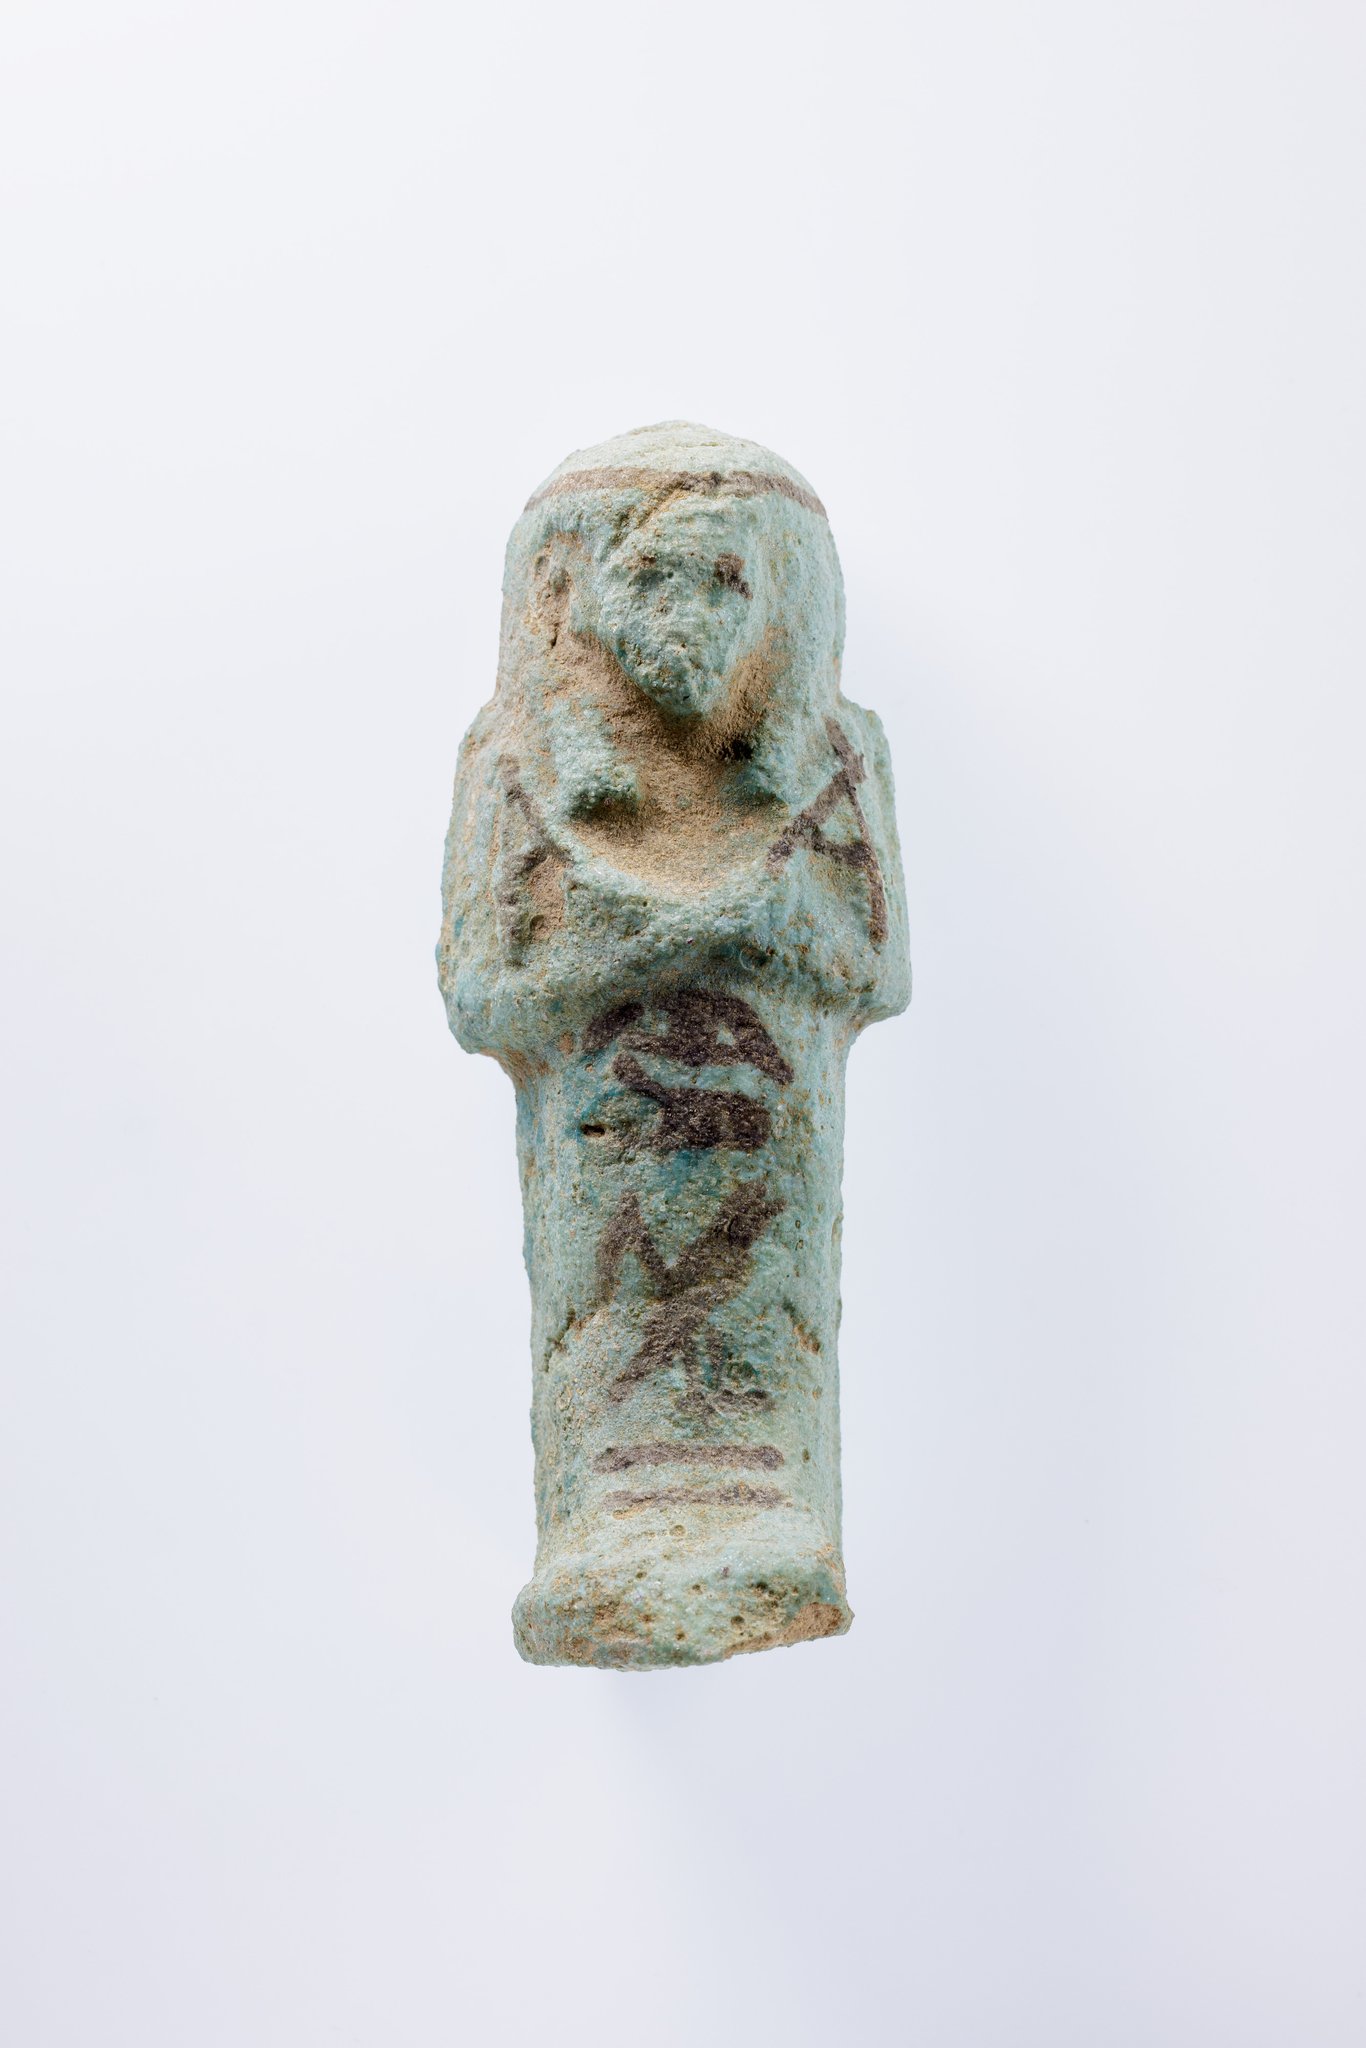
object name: shabti, hor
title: Shabti of Hor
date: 1070-950 BCE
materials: faience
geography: egypt